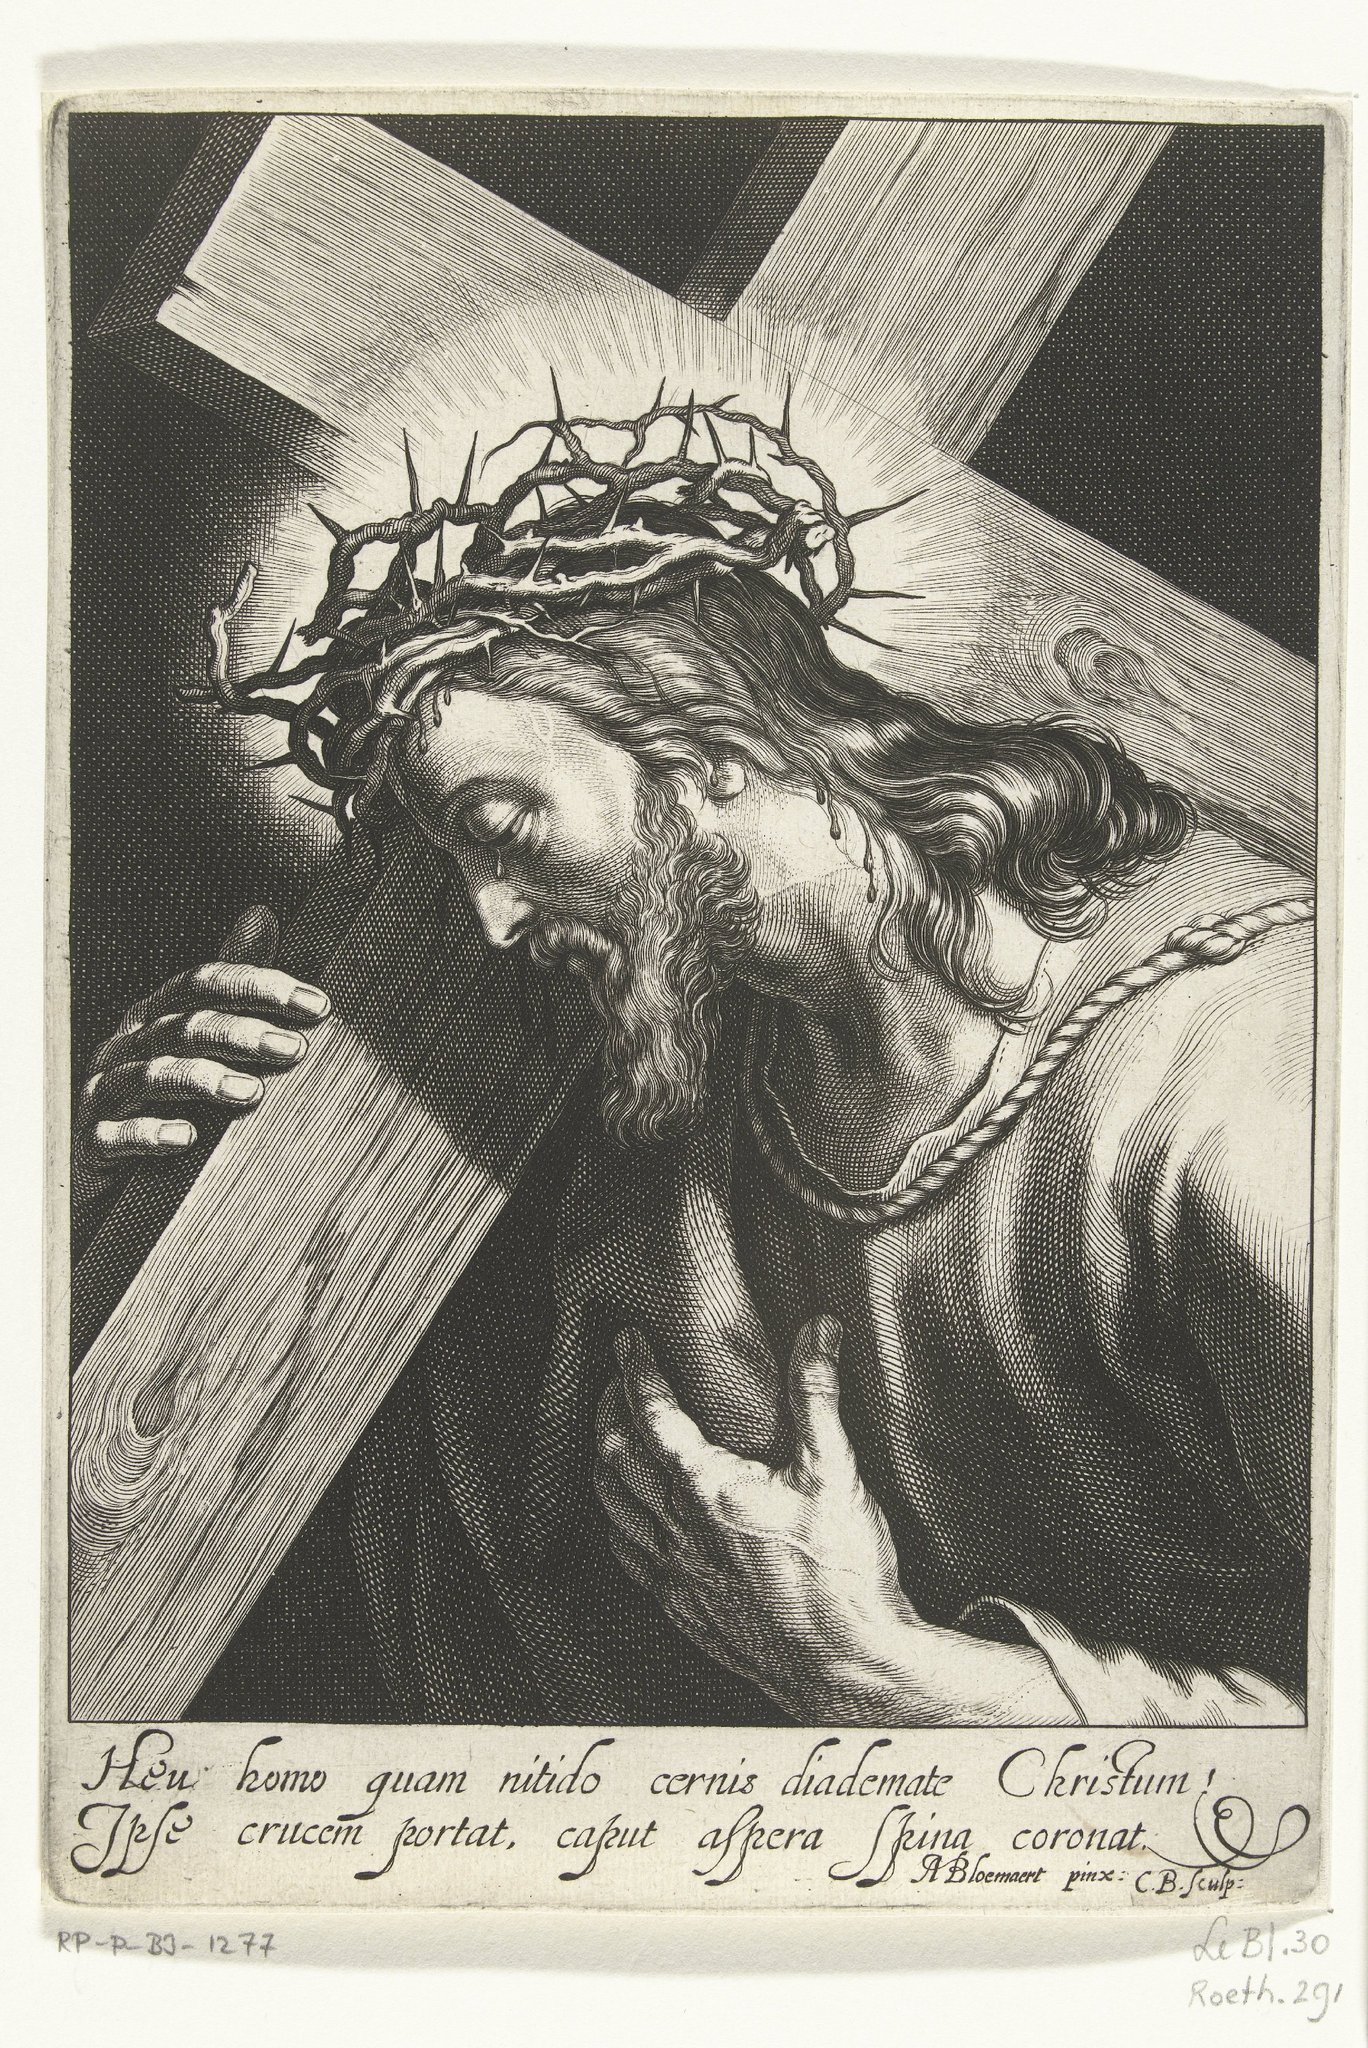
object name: print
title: Christus draagt het kruis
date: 1622-1630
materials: paper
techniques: engraving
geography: utrecht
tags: carrying of the cross: christ bearing the cross, alone or with the help of others (e.g. simon the cyrenian)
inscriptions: collector's mark: Lugt 240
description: Uitsnede van het bovenlichaam van Christus met doornenkrans. Een traan valt uit zijn oog. Op zijn rechterschouder draagt hij het kruis. Met een onderschrift van twee regels in het Latijn.